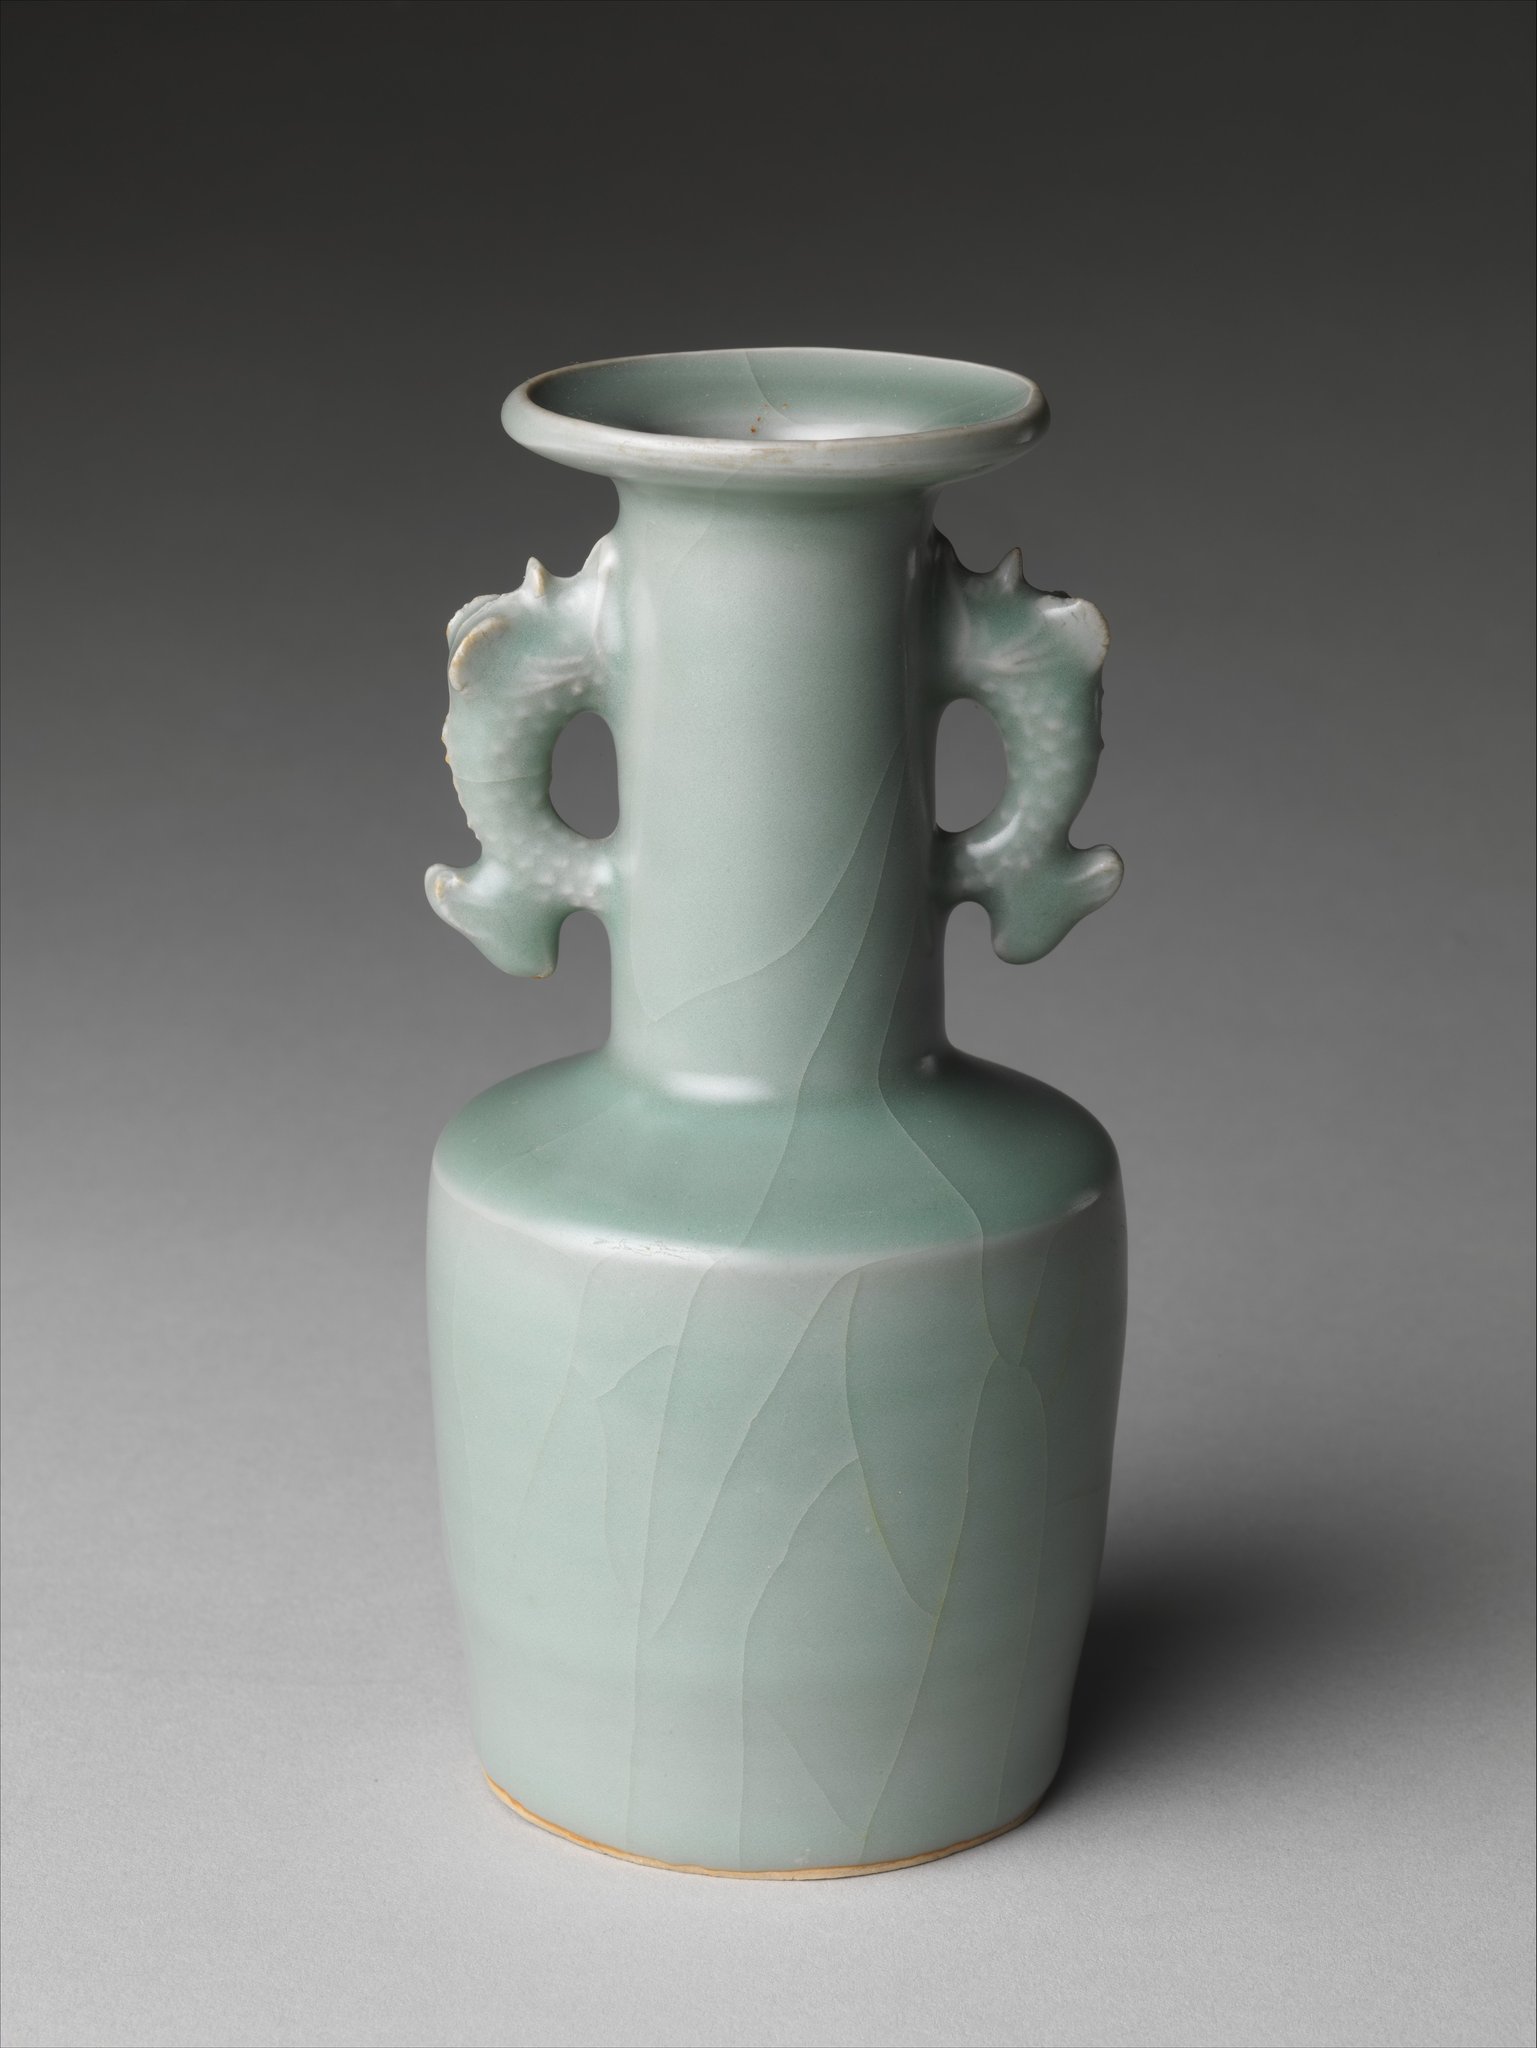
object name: vase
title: Vase with Dragonfish Handles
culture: chinese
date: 1101-1300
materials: ceramic glaze, glaze, porcelain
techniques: relief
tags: fish